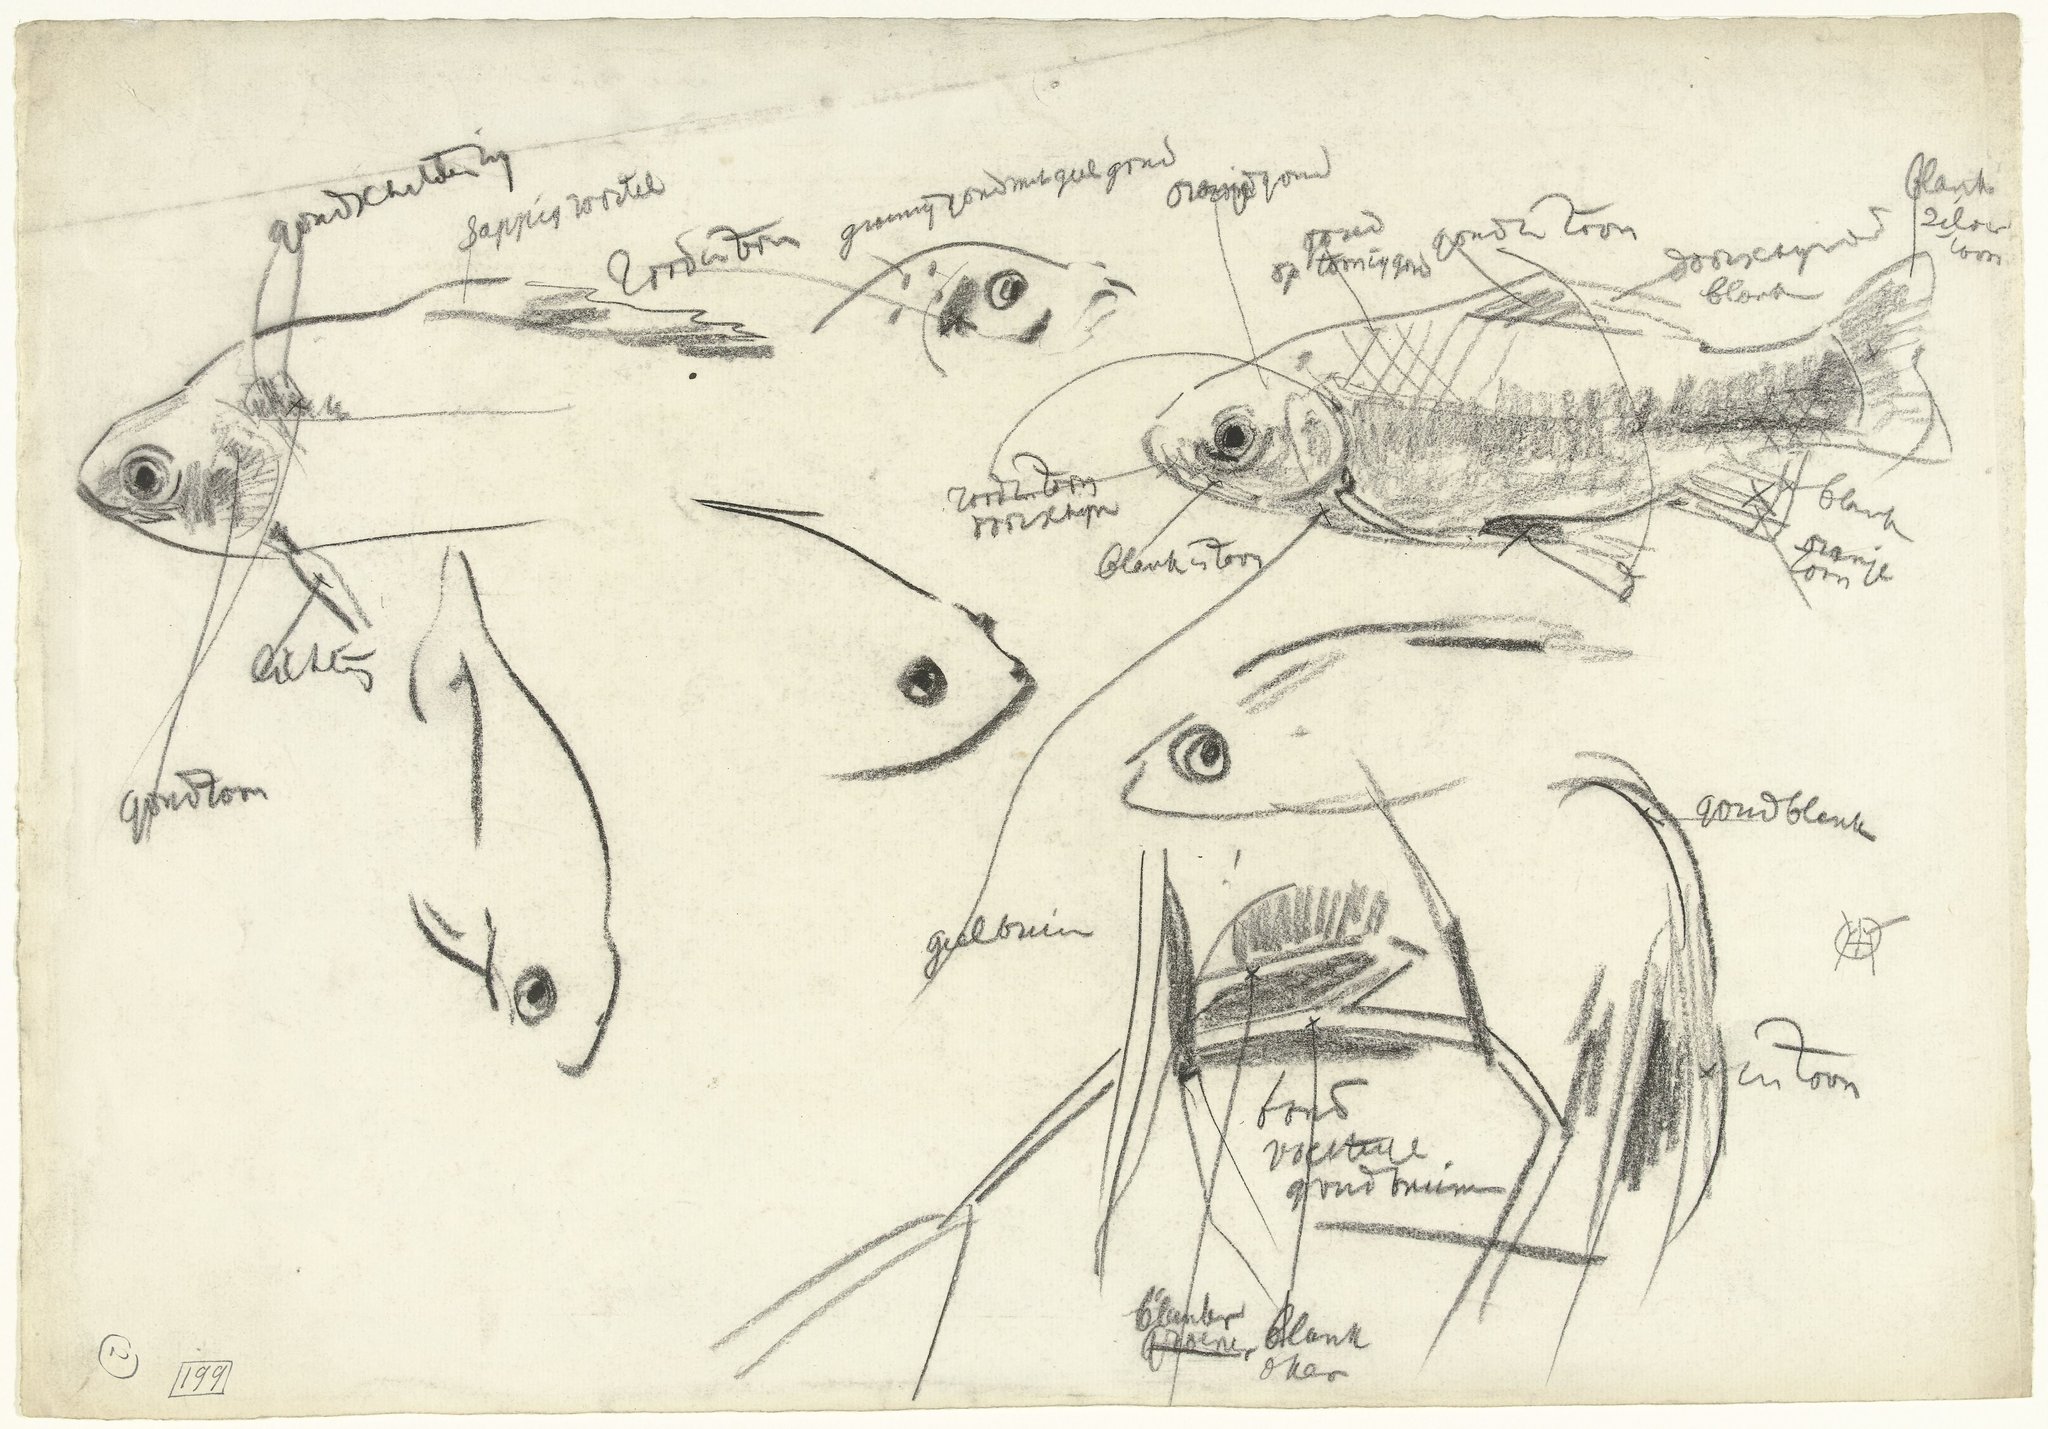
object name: drawing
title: Detailstudies van vissen, met kleurnotities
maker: gerrit willem dijsselhof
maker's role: designer, draughtsman, print maker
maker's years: 1866-1924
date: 1876-1924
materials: chalk, paper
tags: bony fishes